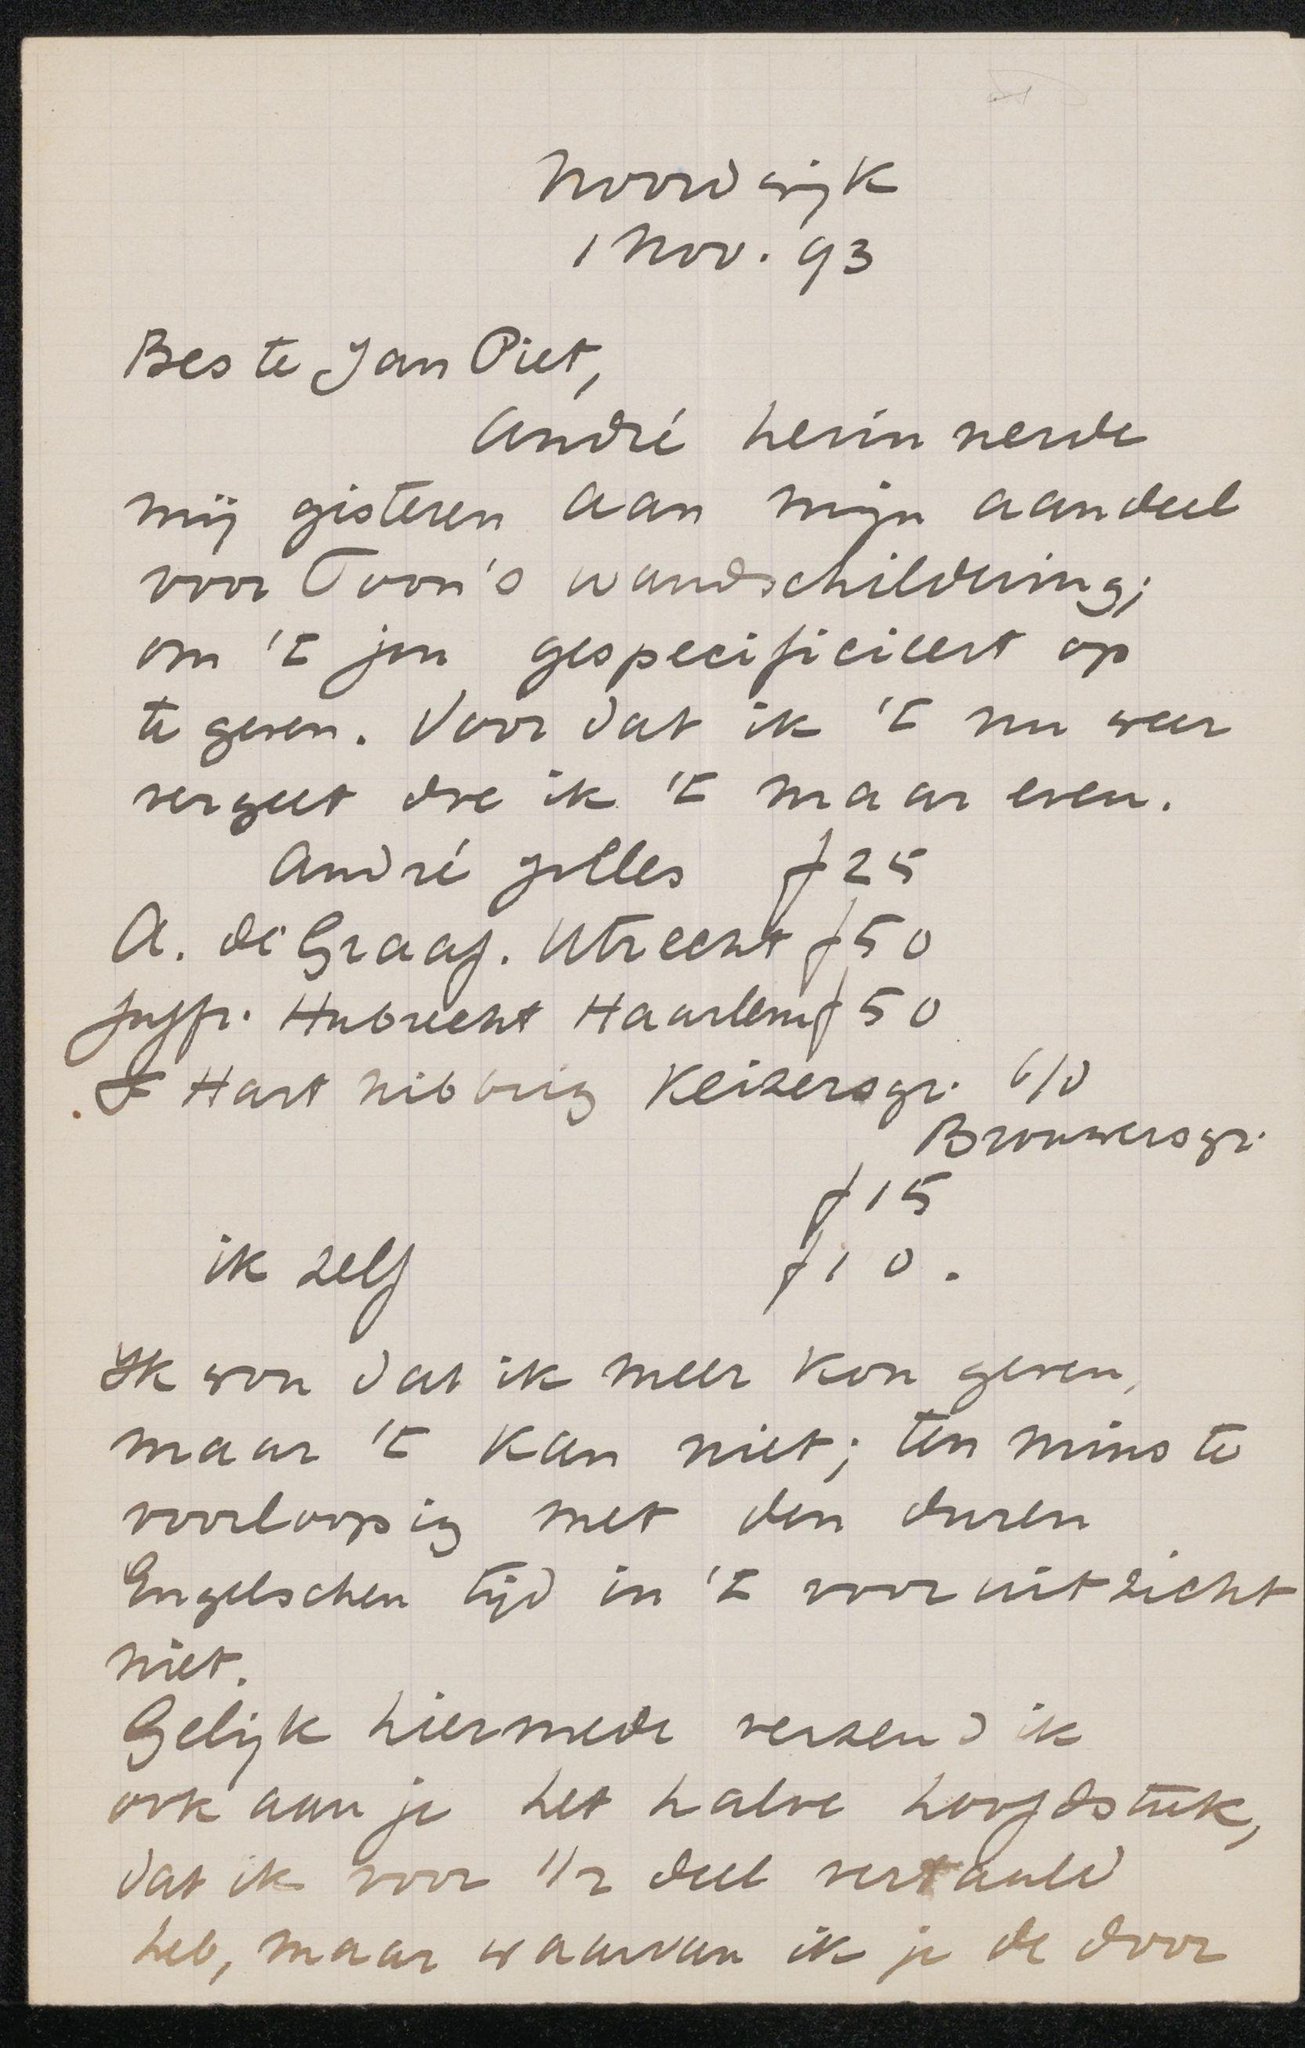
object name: letter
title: Brief aan Jan Veth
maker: richard nicolaüs roland holst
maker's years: 1868-1938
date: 1893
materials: ink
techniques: pen, writing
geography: noordwijk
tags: designer, jan veth, amsterdam, painter, print maker, draughtsman, ferdinand hart nibbrig, den bosch, antoon derkinderen, andré jolles, rotterdam, the monumental arts, money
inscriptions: collector's mark: ‘RPK’